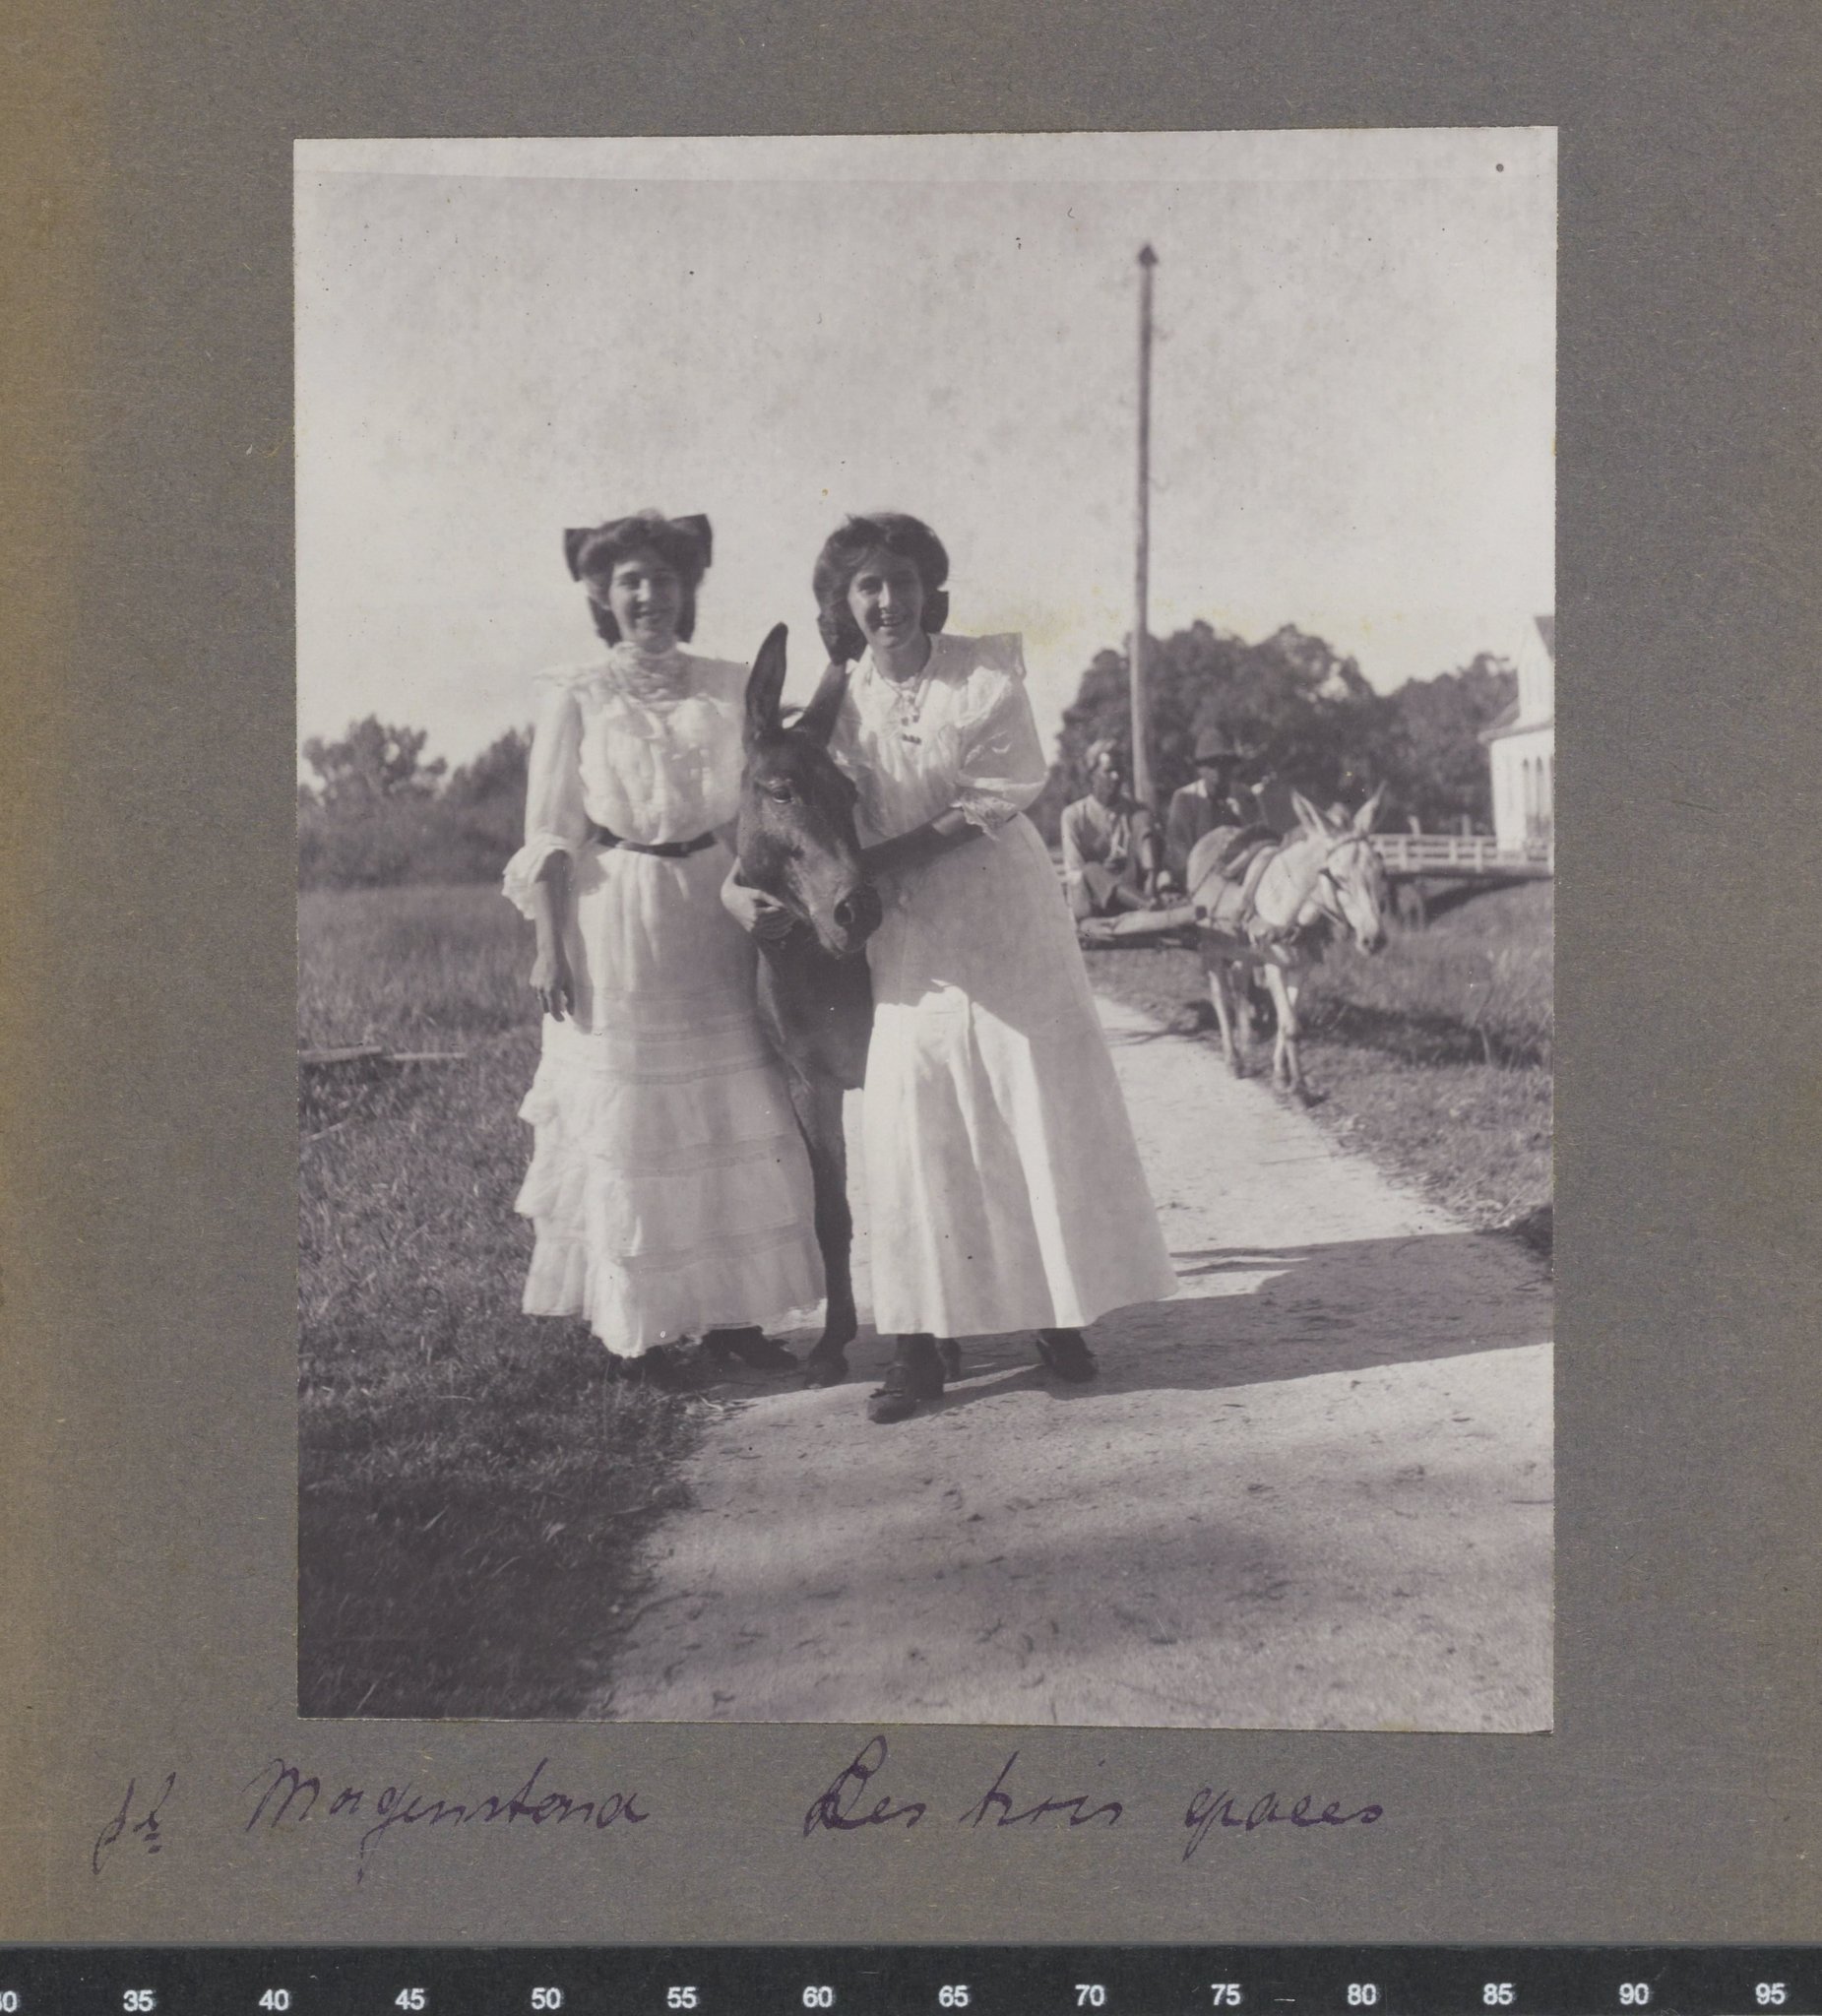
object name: photograph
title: Les trois graces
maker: Anonymous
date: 1912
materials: photographic support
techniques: photography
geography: suriname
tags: plantation, ass, donkey, suriname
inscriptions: inscription: ‘pl. Morgenstond Les trois graces’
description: Maria Gonggrijp poseert met een vriendin en een ezel tussen hen in. Rechts een kar met een ezel ervoor. Op plantage Morgenstond. Onderdeel van het fotoalbum over het leven van de familie Gonggrijp in Suriname rond 1912.